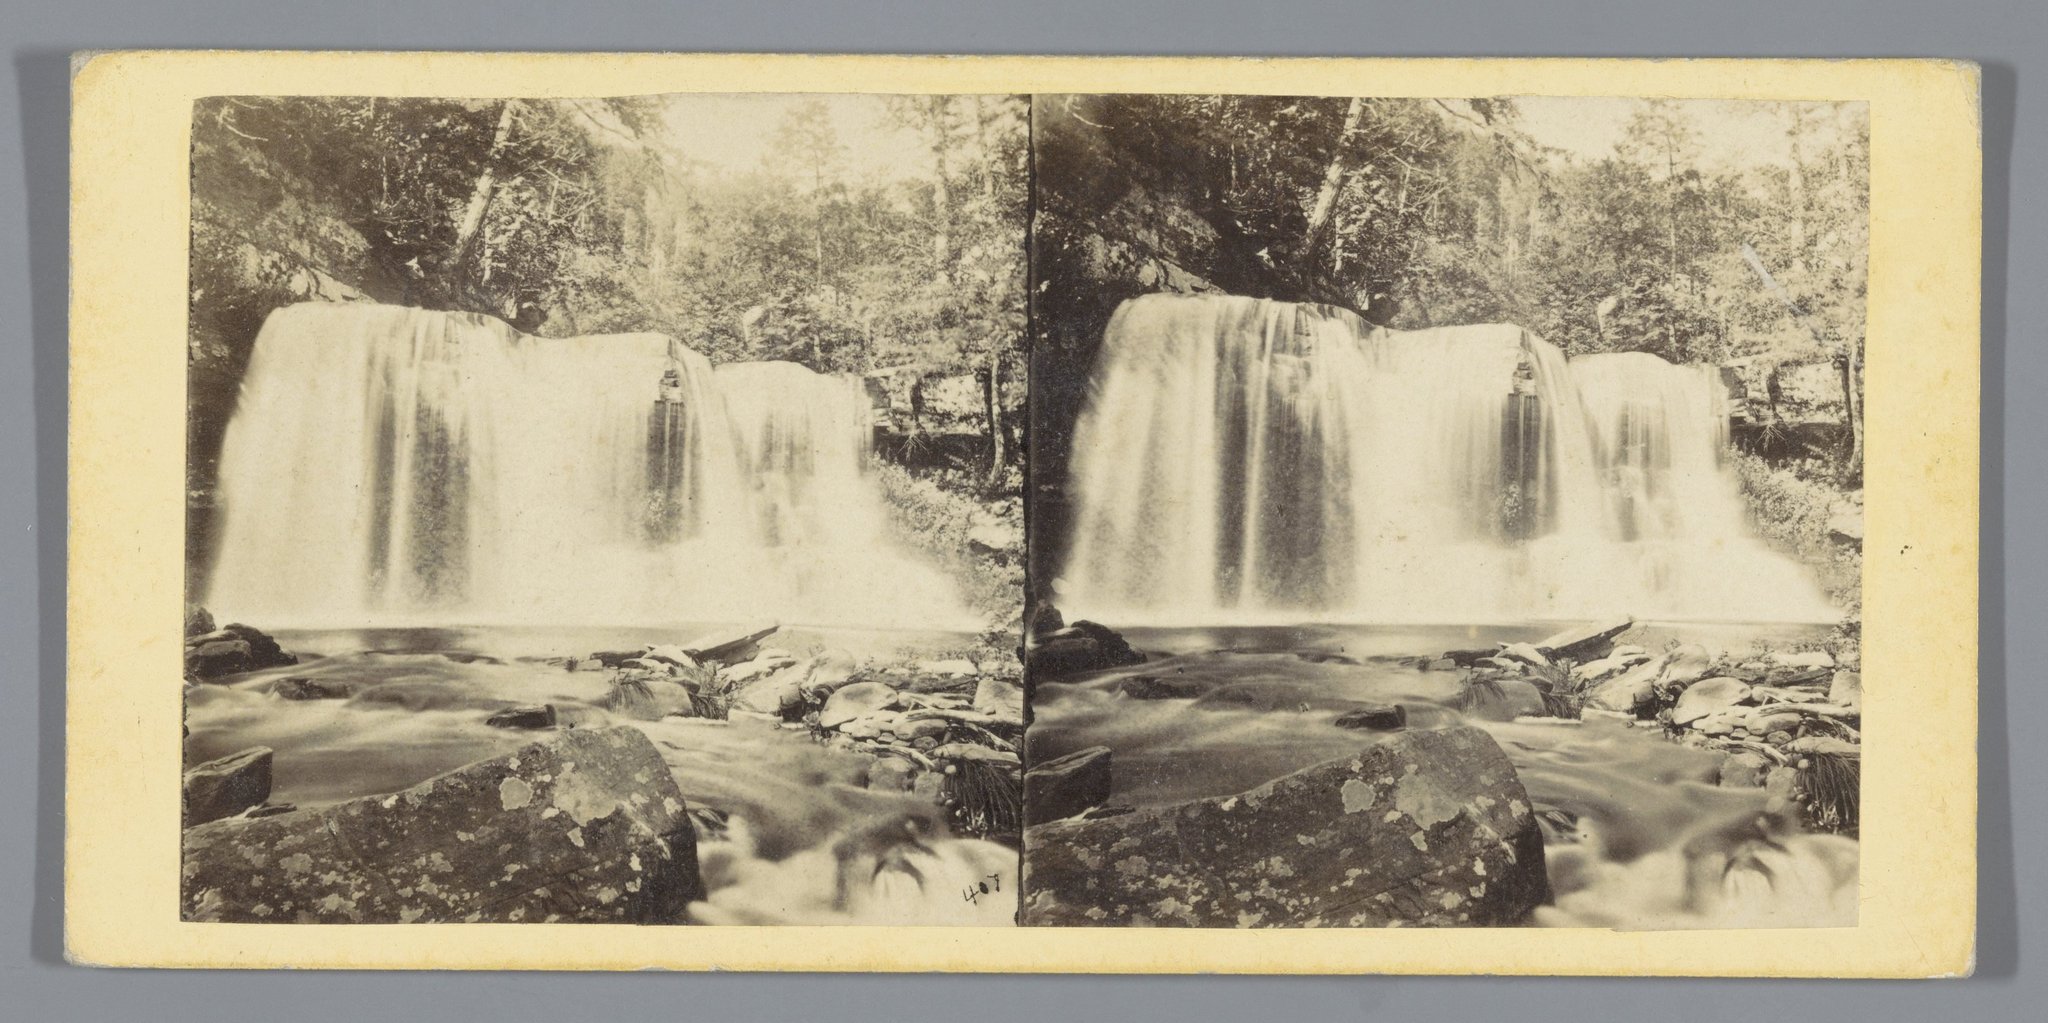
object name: stereograph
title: Bastion Fall in the Kauterskill Gorge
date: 1857-1862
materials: cardboard, paper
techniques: albumen print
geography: new york city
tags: waterfall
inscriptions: address: ‘501 Broadway, New-York’, inscription: ‘/1111’, number: ‘407’